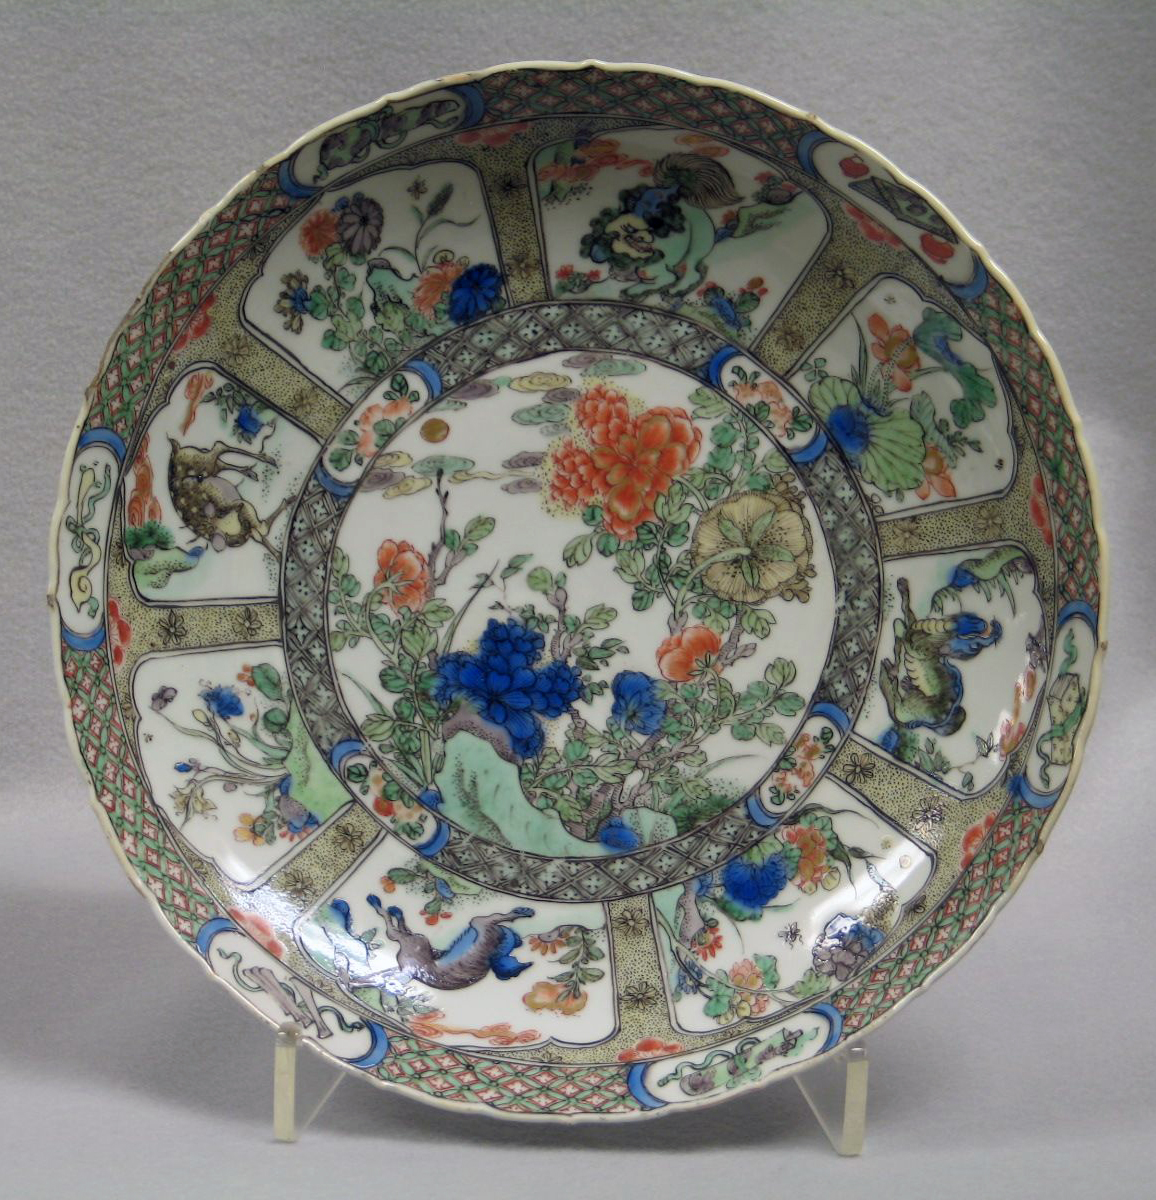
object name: dish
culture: chinese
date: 1662-1722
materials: porcelain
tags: animals,flowers,leaves